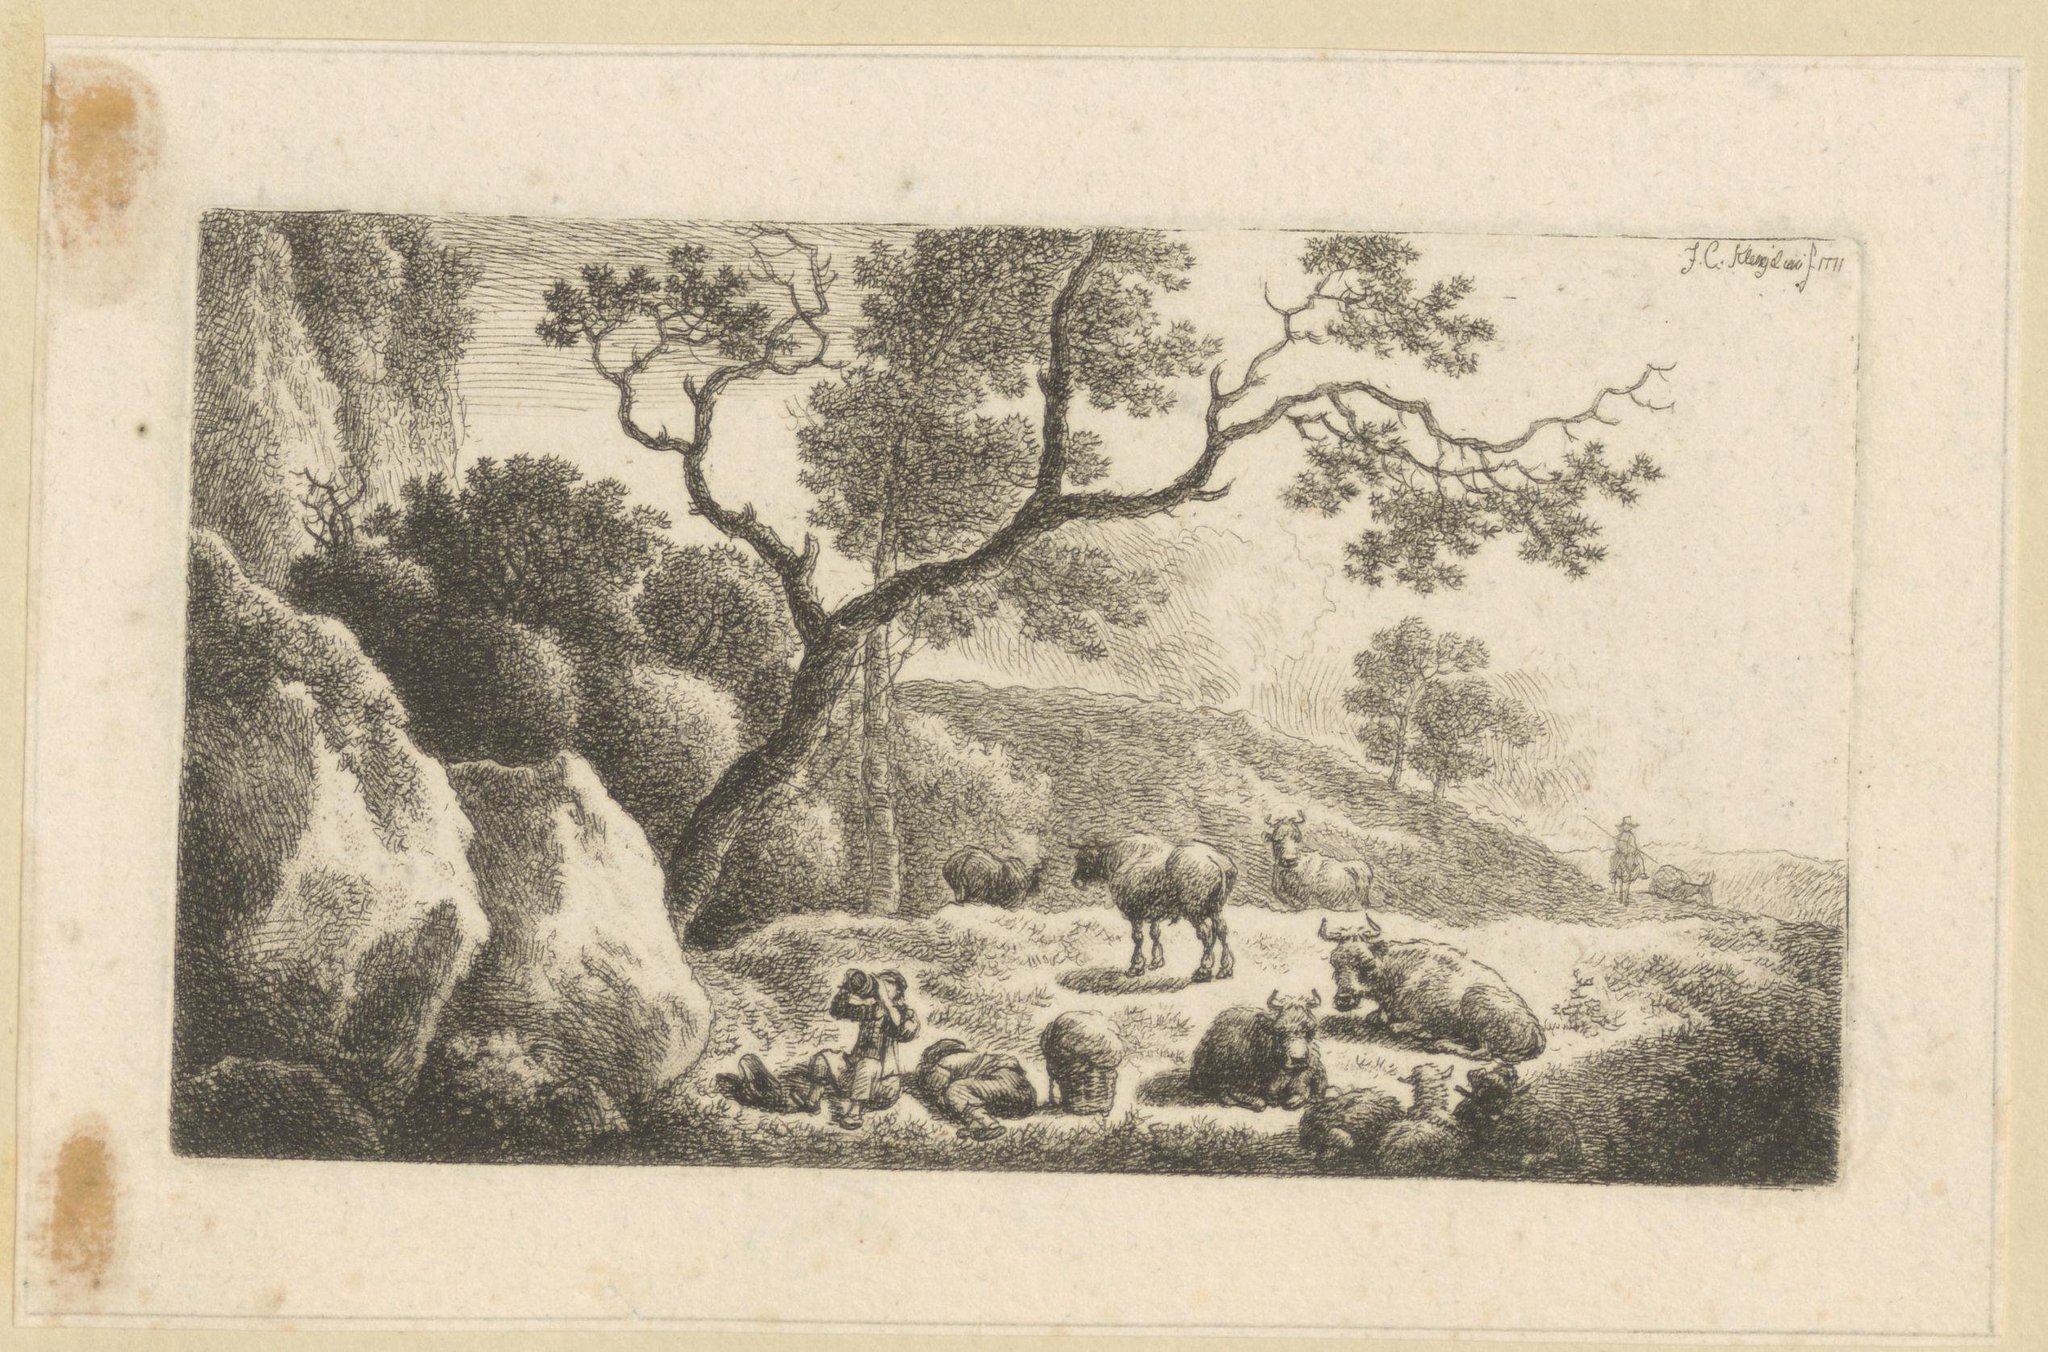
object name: print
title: Landschap met rustende herders en kudde runderen en schapen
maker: johann christian klengel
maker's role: print maker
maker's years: 1751-1824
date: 1771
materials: paper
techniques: etching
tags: herding, herdsman, herdswoman, shepherd, shepherdess, cowherd, etc., cattle, (traveller) resting in the open air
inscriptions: collector's mark: Lugt 240